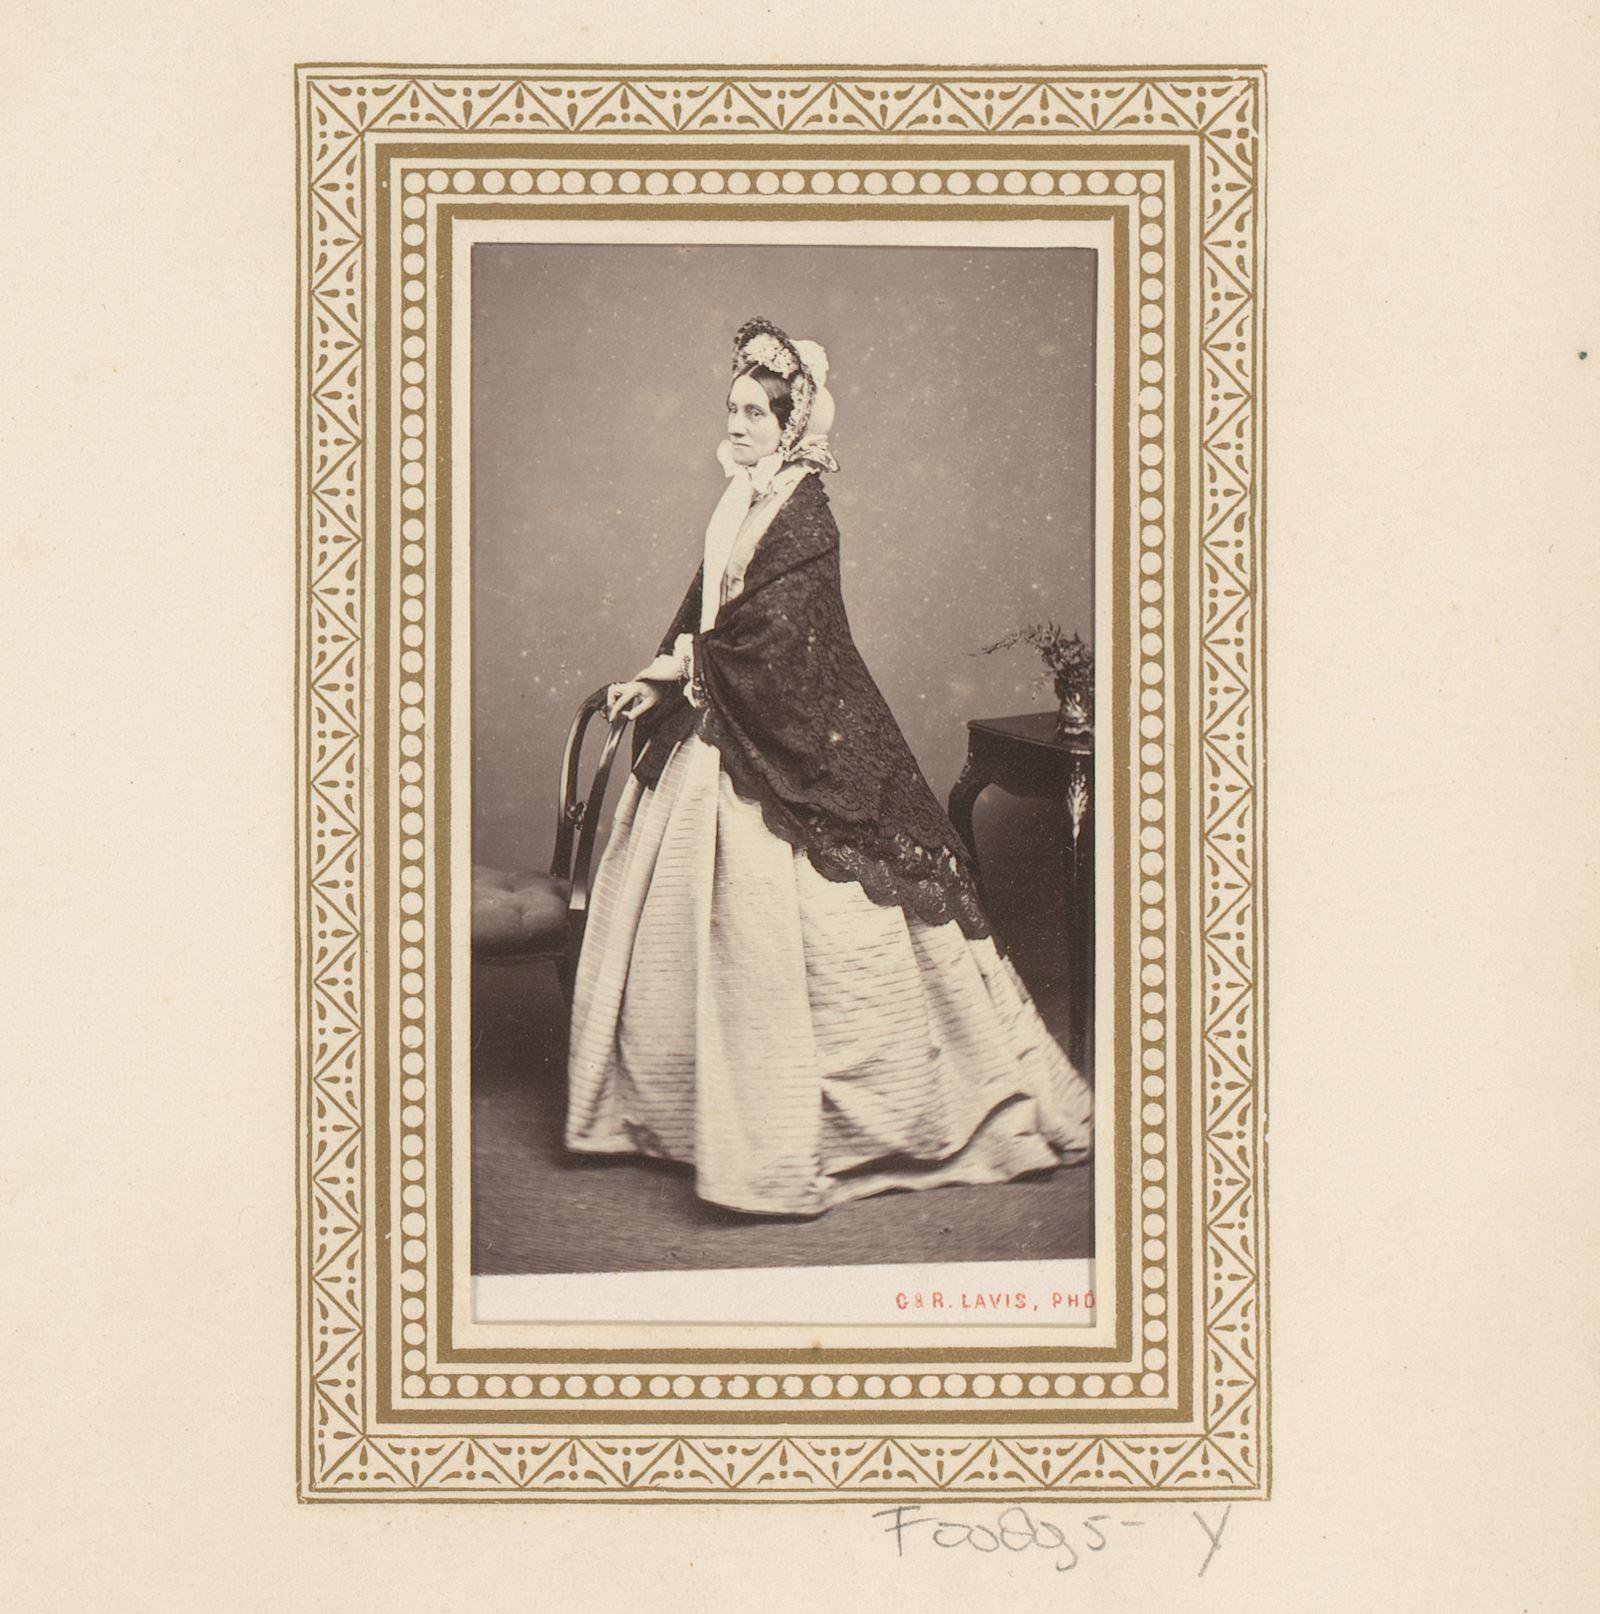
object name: carte de visite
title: Portret van een staande vrouw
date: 1863-1875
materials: cardboard, photographic support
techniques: albumen print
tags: historical persons, standing figure - aa - female human figure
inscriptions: inscription: ‘G & R Lavis/ Photographers 8/ Miniature Painters/ 135 Regent st/ W.’